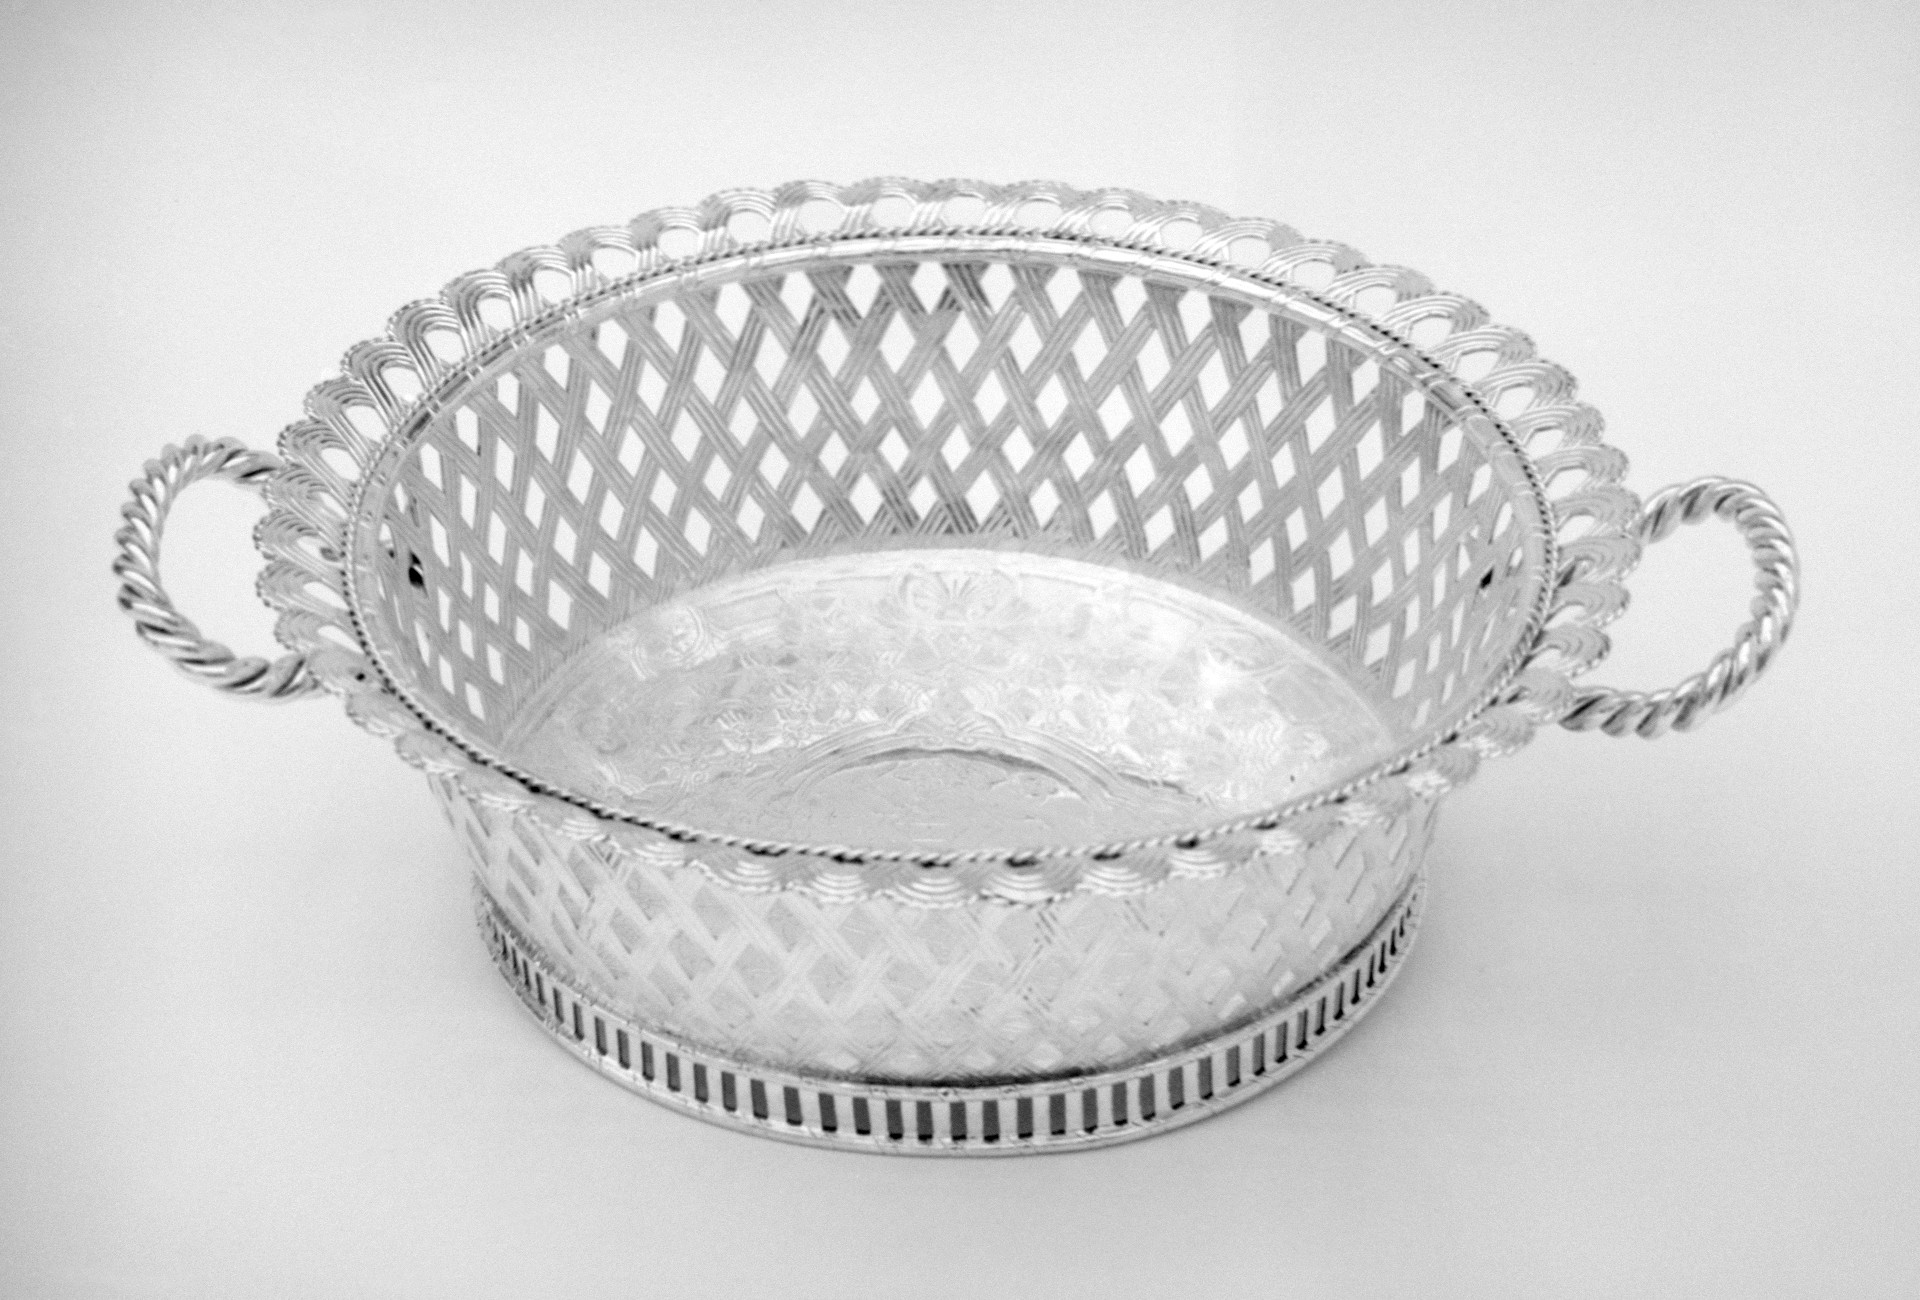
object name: basket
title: Basket (one of a pair)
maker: paul de lamerie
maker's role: maker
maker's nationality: british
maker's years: 1688-1751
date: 1729-1730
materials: silver